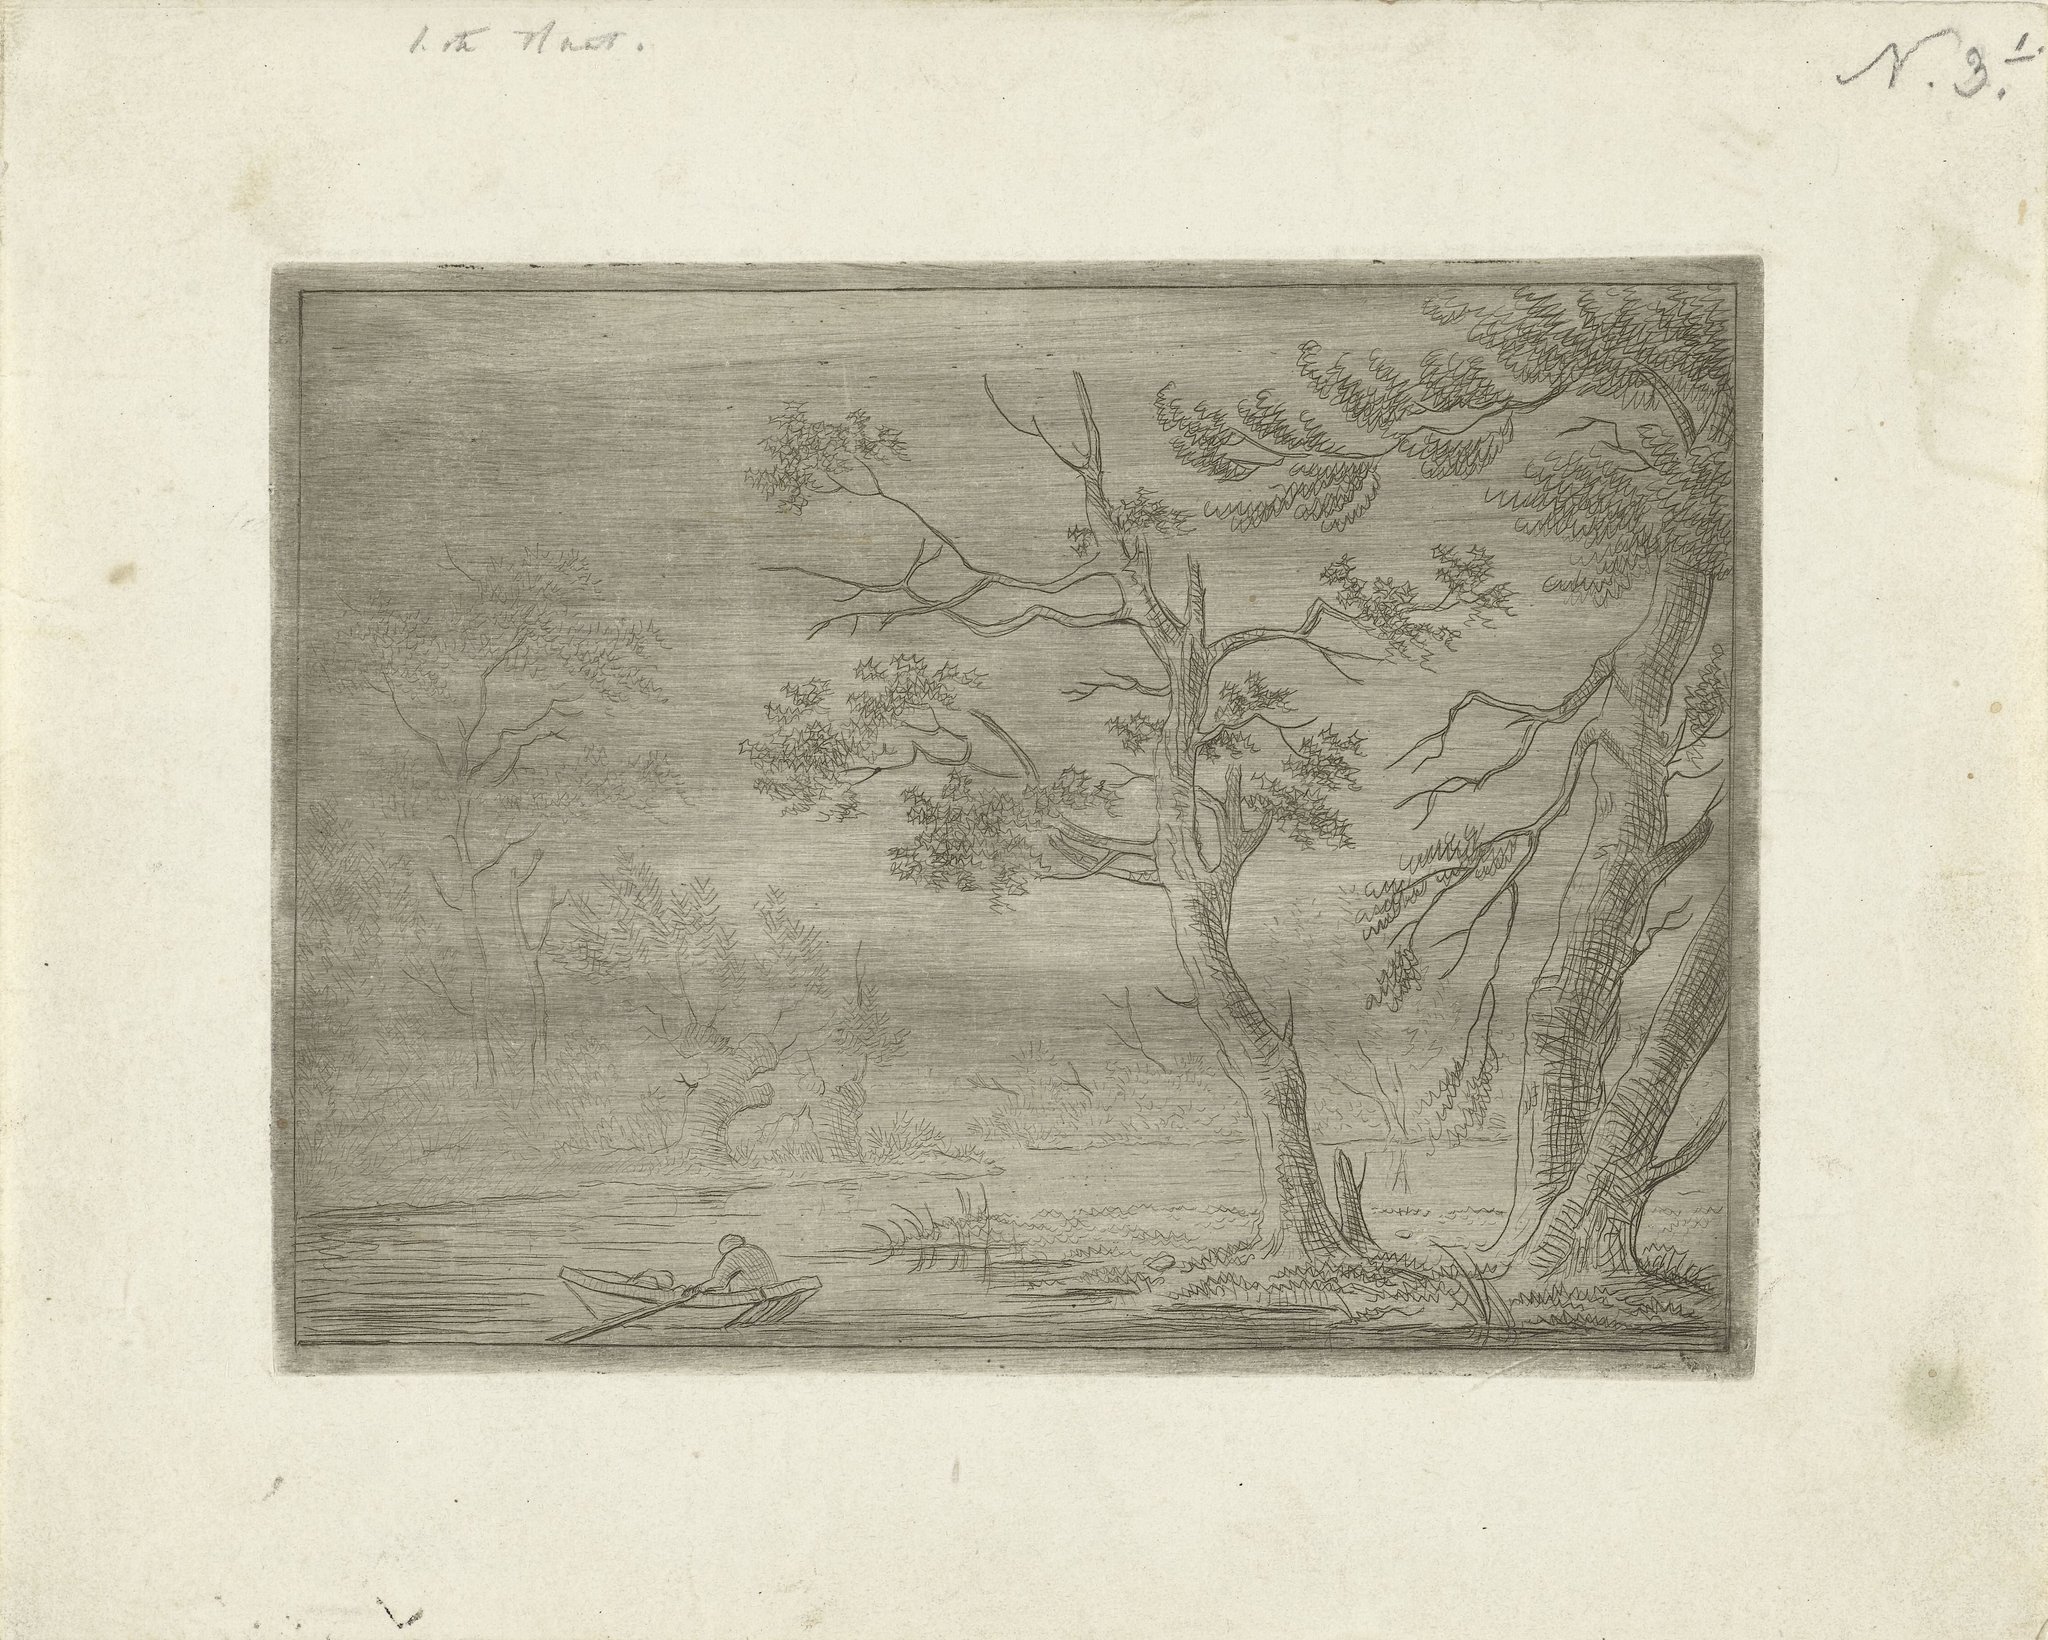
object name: print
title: Nachtgezicht met een figuur in een boot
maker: cornelis van der griendt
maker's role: draughtsman, painter, print maker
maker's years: 1827-1918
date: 1850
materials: paper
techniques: etching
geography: netherlands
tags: rowing-boat, canoe, etc., windmill, landscapes with waters, waterscapes, seascapes (in the temperate zone) - hh - ideal landscapes (+ landscape with figures, staffage)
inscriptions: collector's mark: Lugt 2228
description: Nachtgezicht met een figuur in een roeiboot omgeven door water en bomen. Op de achtergrond een kerktoren en twee molens.